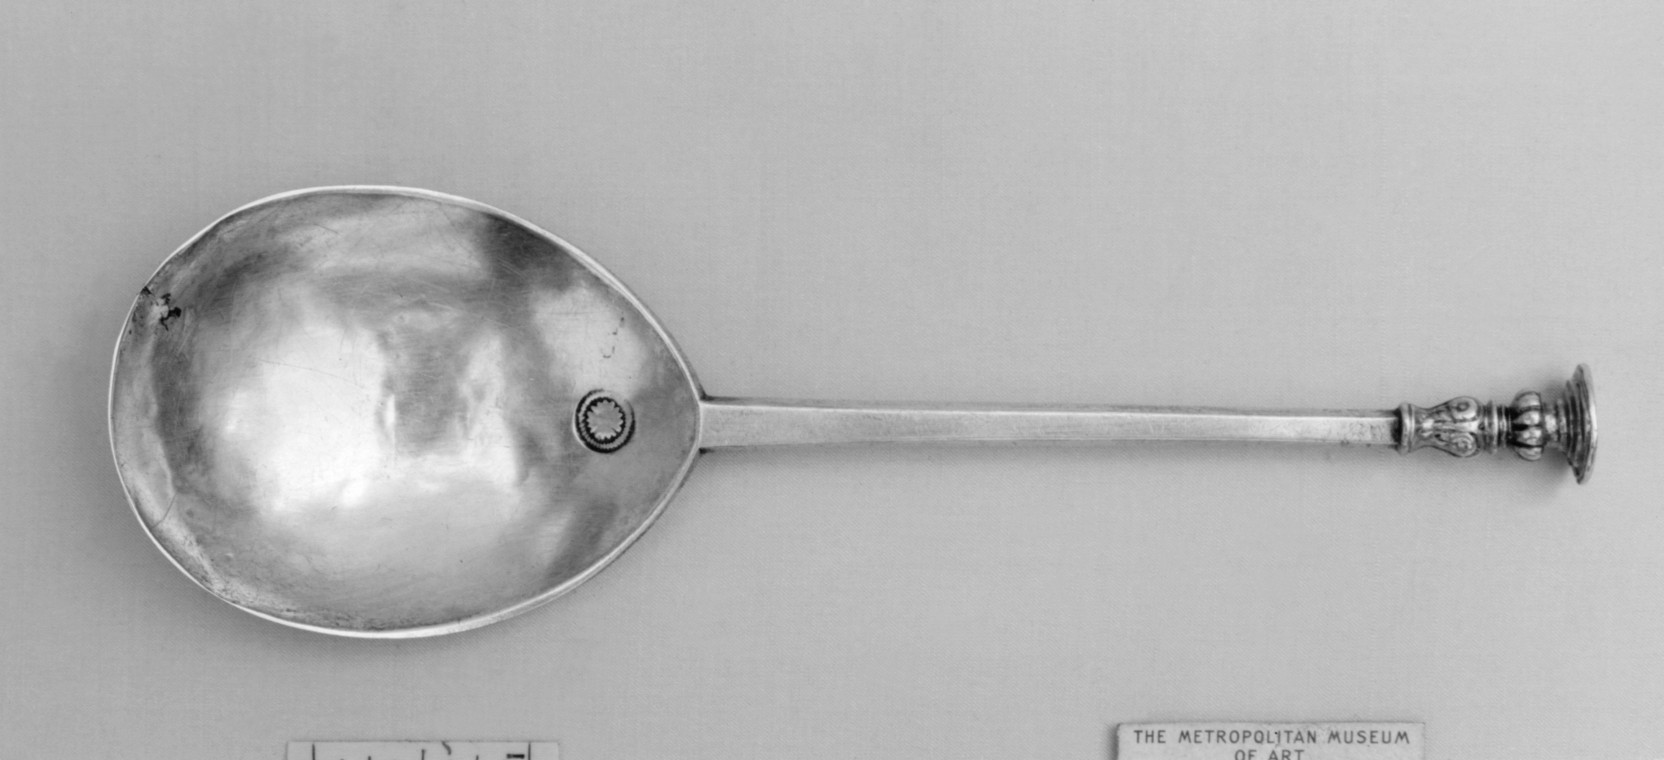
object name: spoon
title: Seal-top spoon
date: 1580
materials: gilt, silver